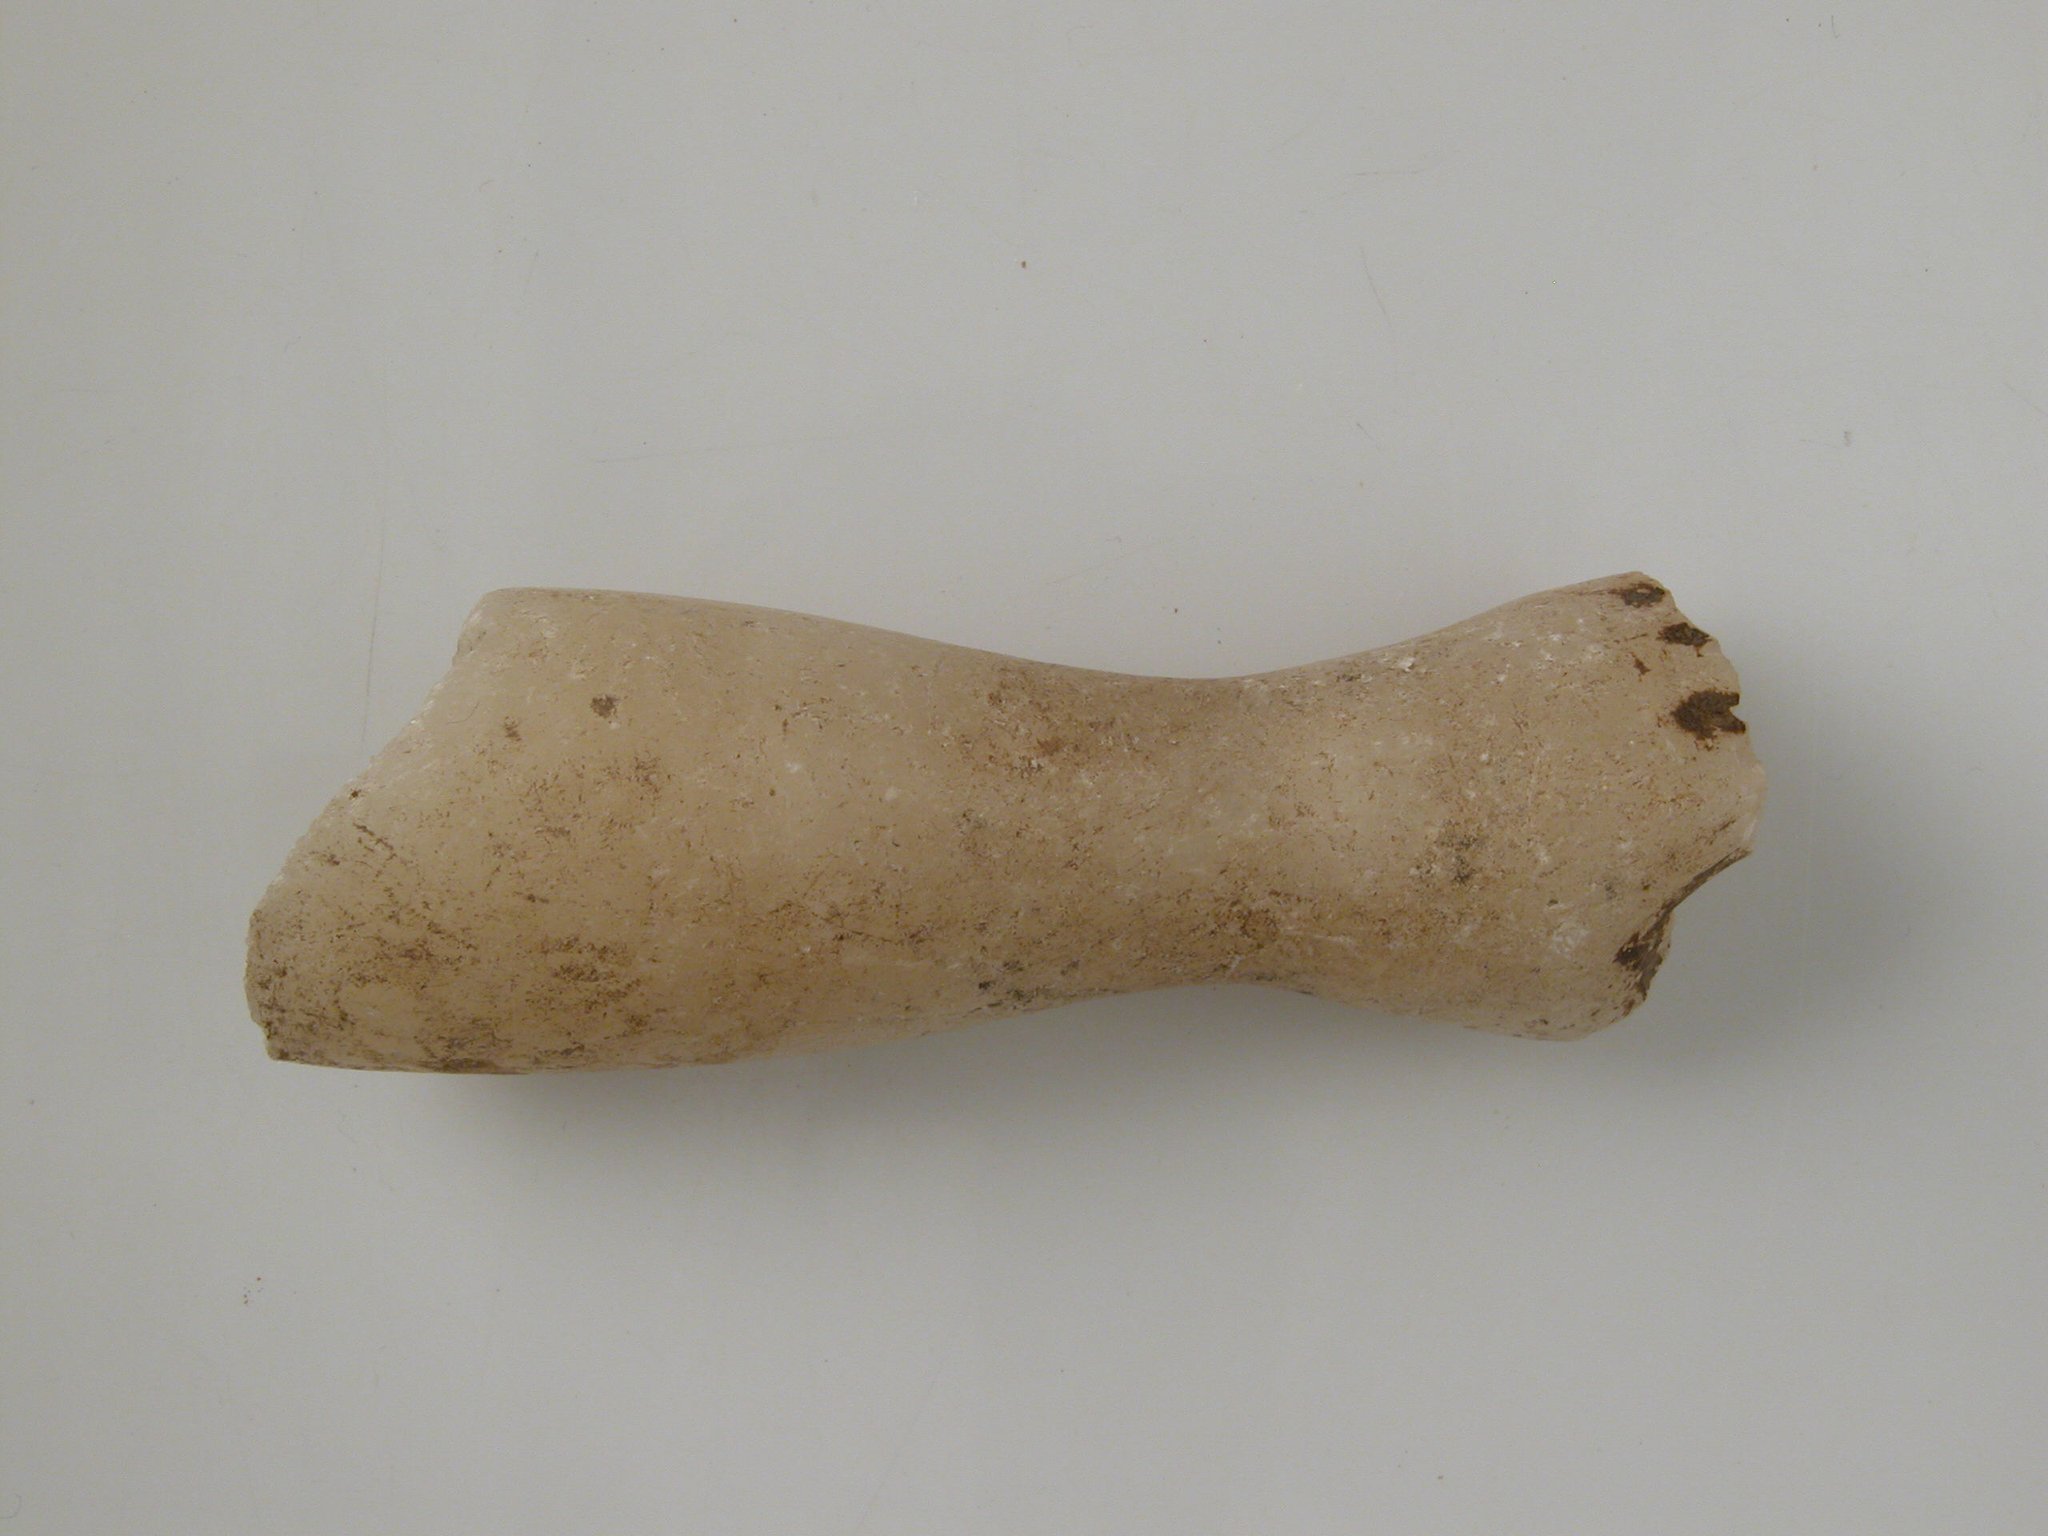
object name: statuette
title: Lower Arm Fragment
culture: coptic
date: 301-700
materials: alabaster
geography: egypt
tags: arms